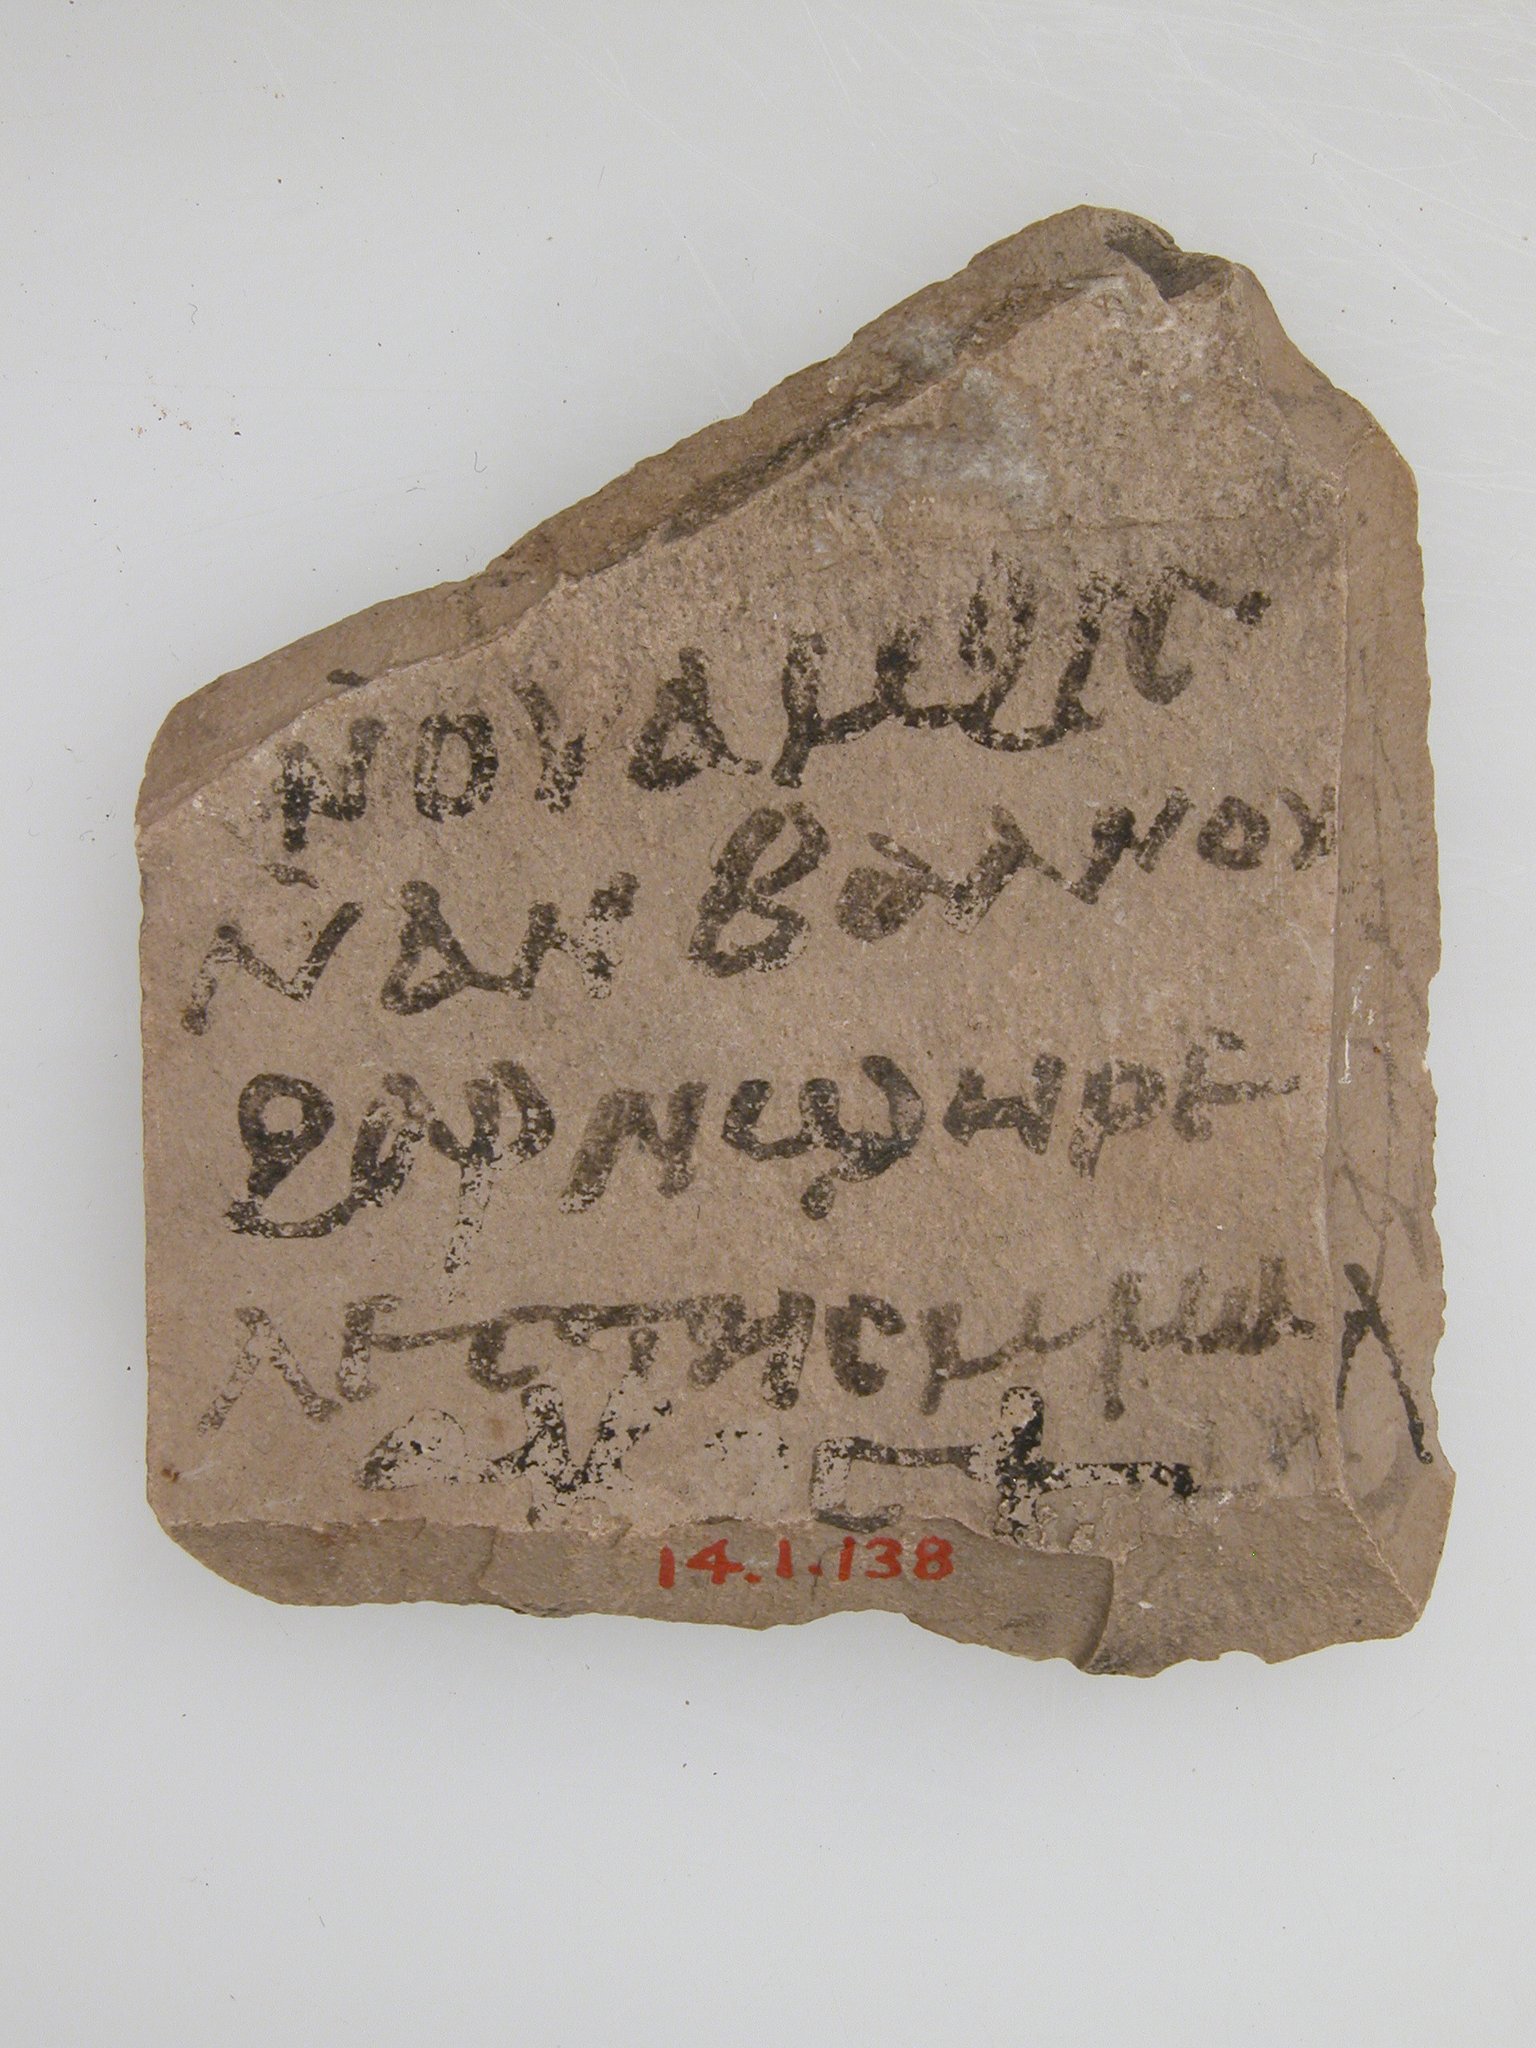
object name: ostrakon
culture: coptic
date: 600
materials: ink, limestone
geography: egypt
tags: coptic,documents